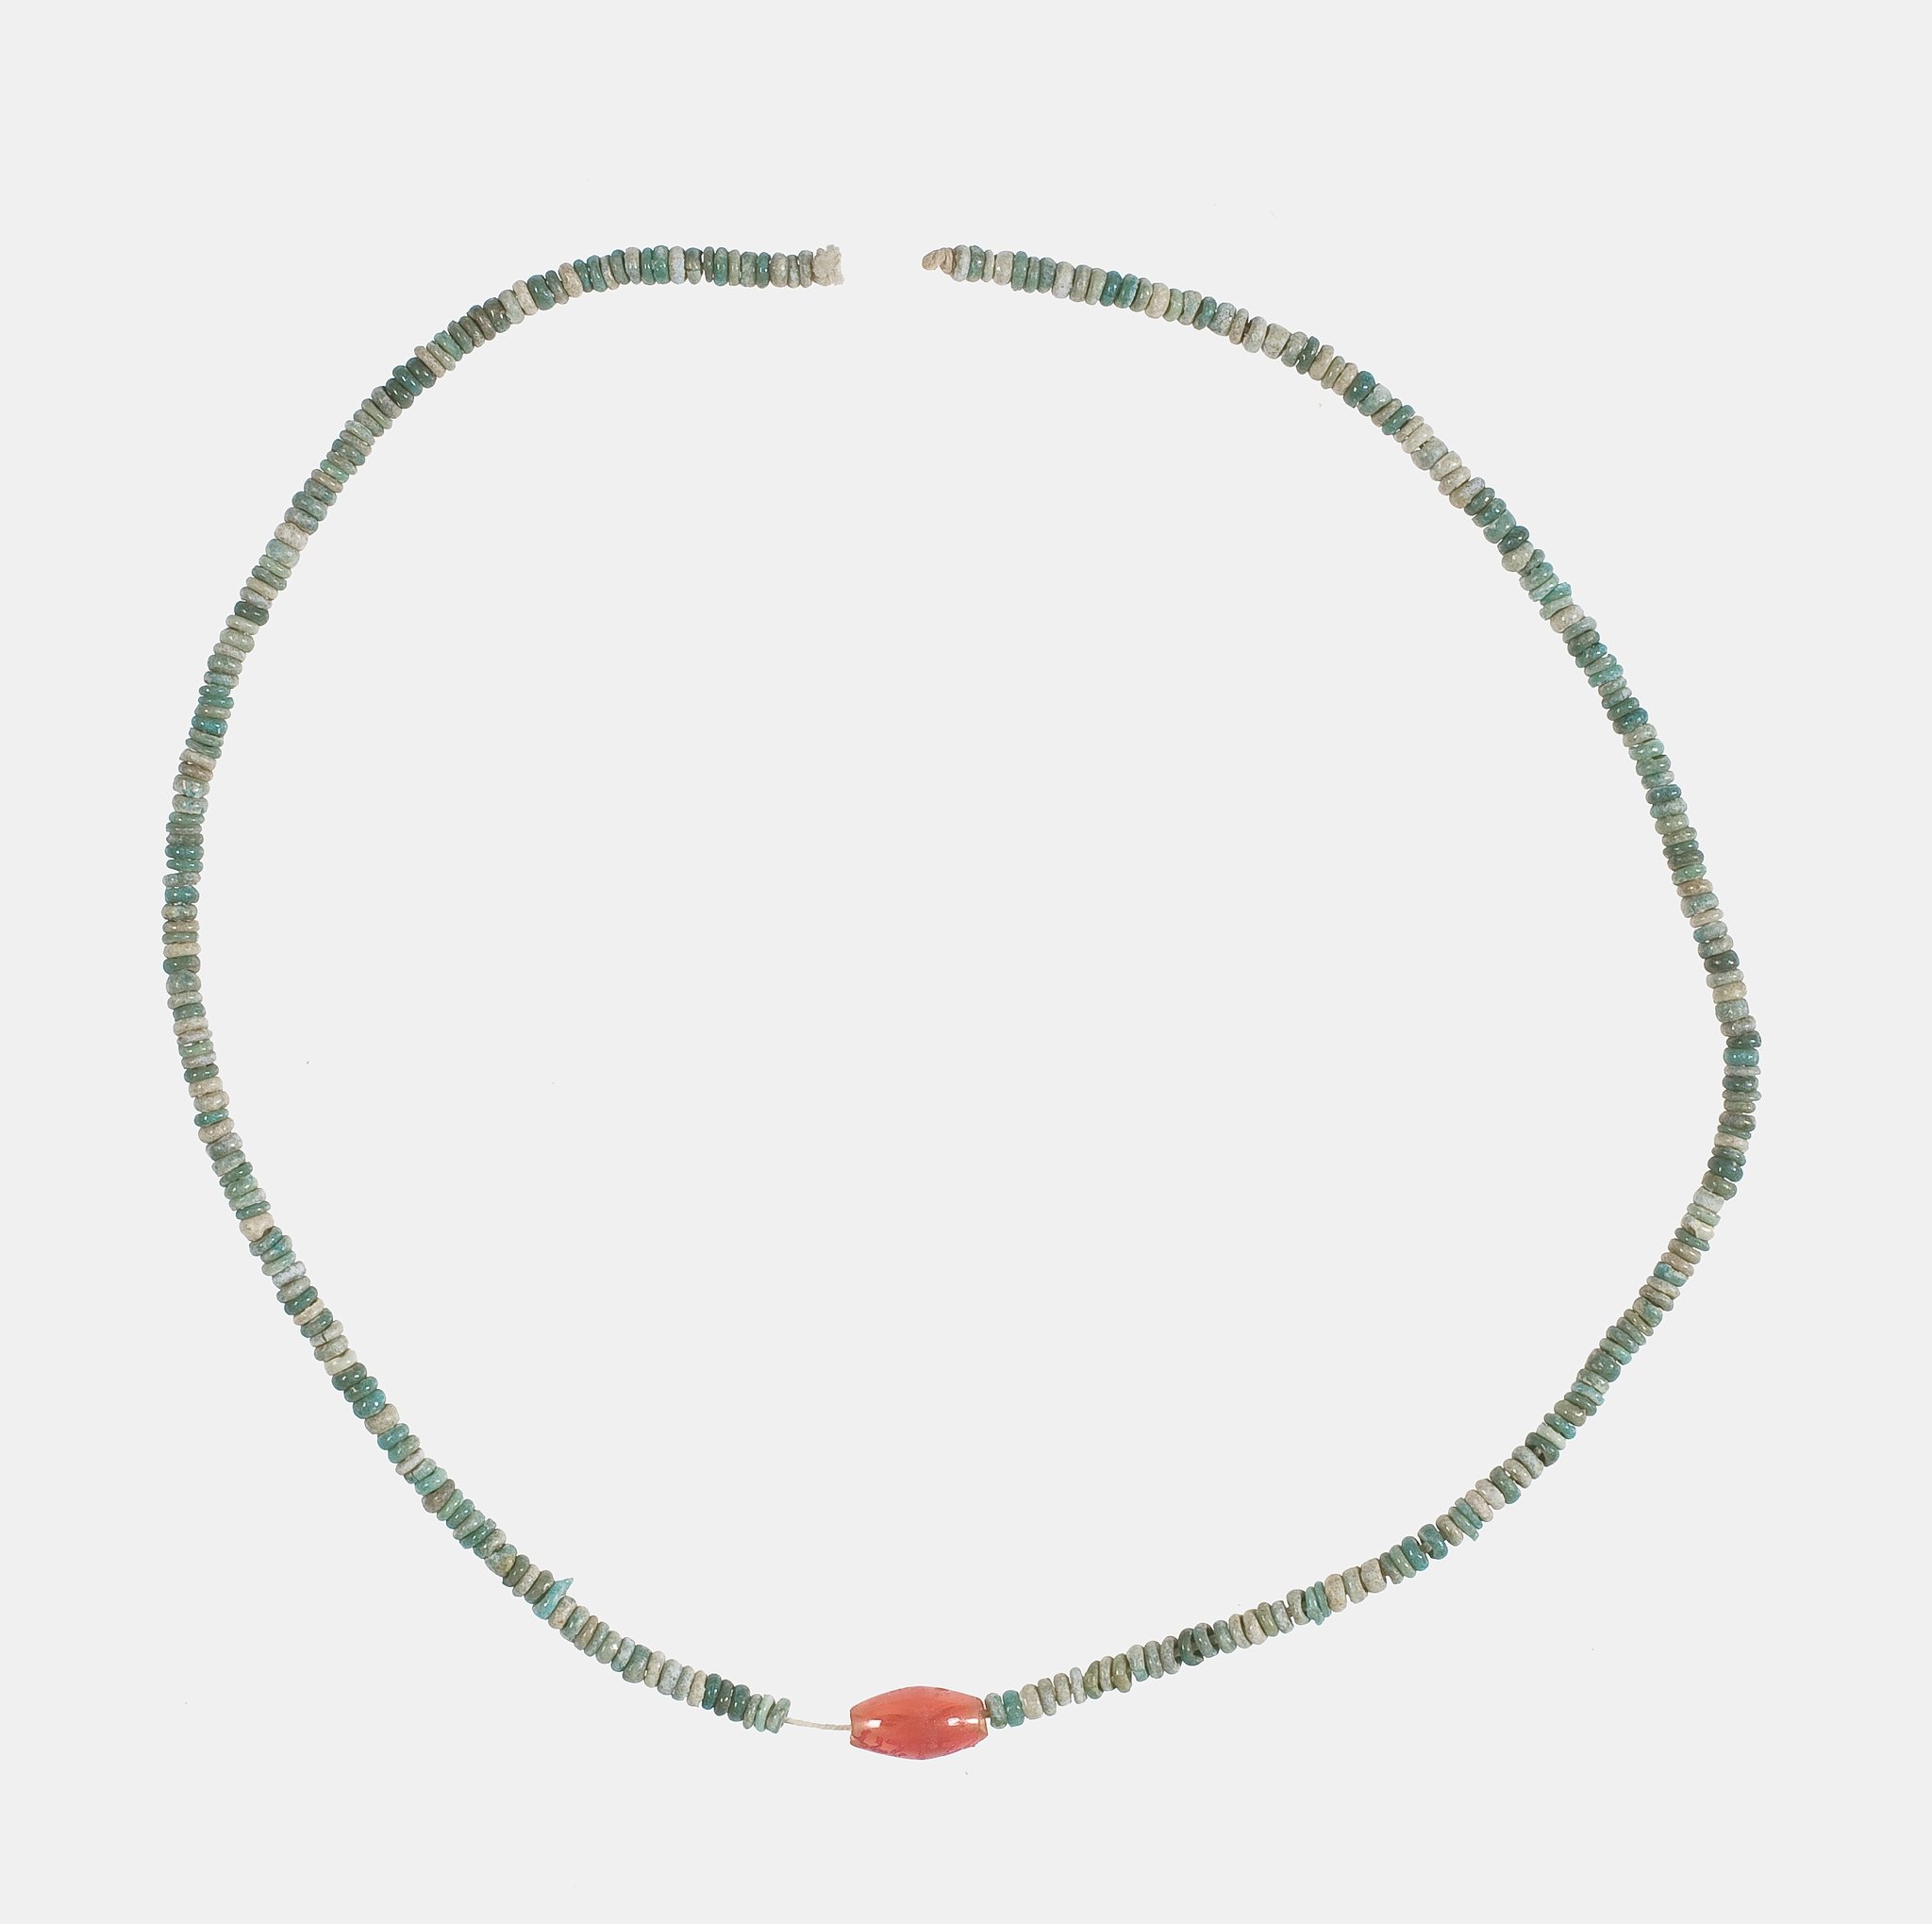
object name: necklace, barrel bead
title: Necklace with carnelian barrel bead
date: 1981-1640 BCE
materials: gemstone, faience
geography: egypt